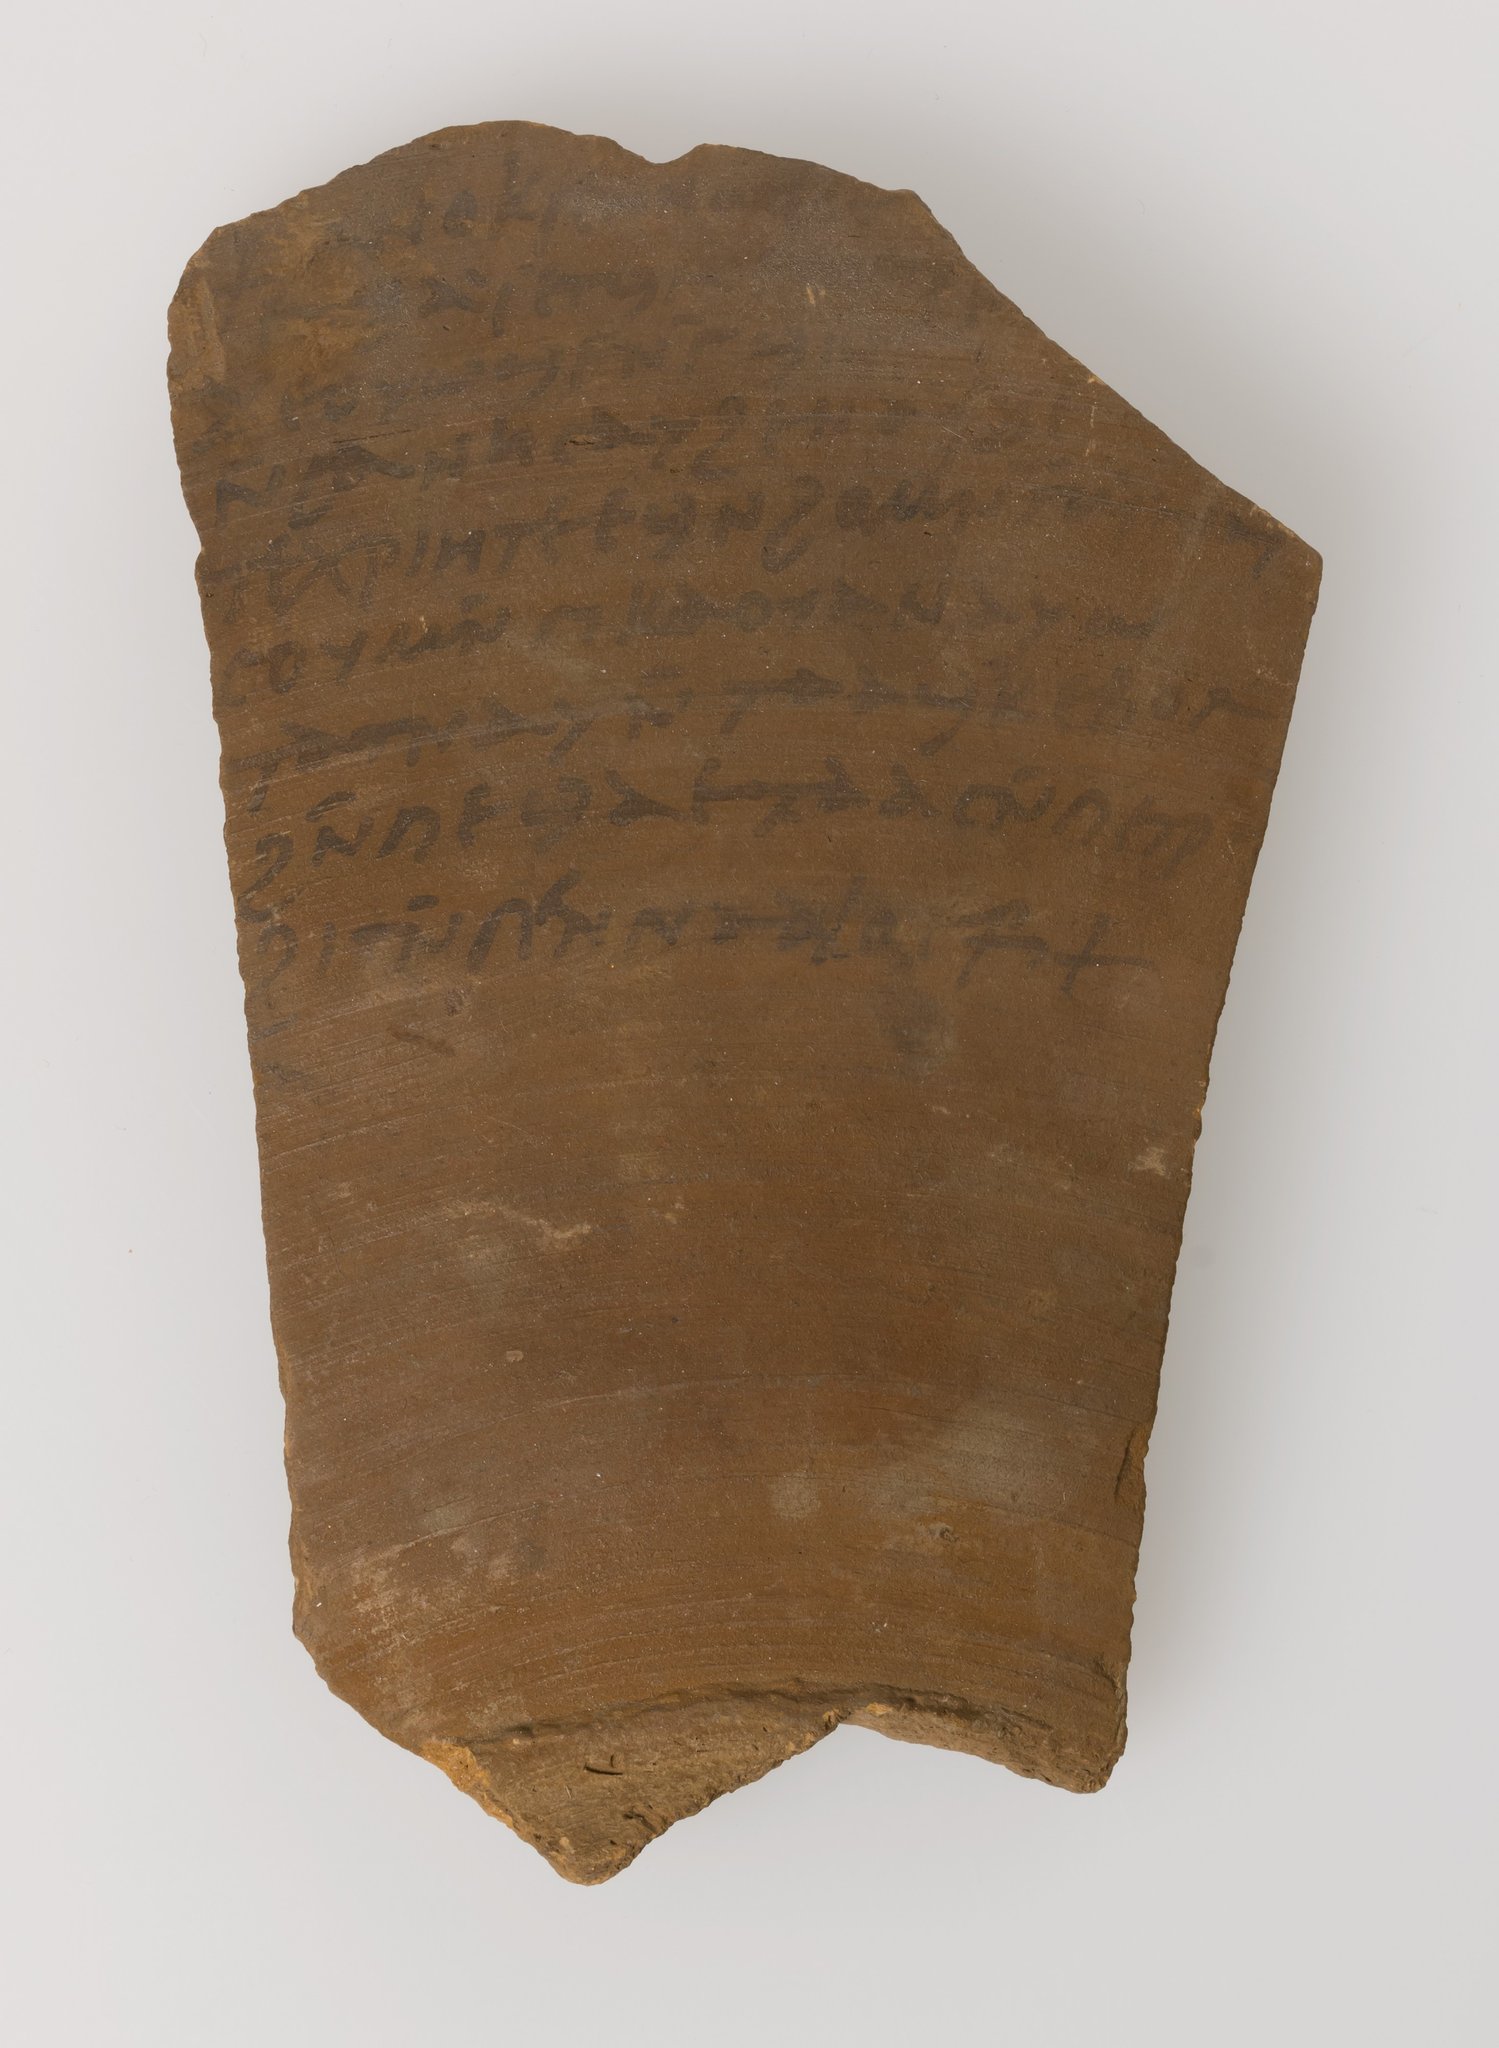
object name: ostrakon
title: Ostrakon with a Letter from Gennadius to Peter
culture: coptic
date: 580-640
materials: ink, pottery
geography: egypt